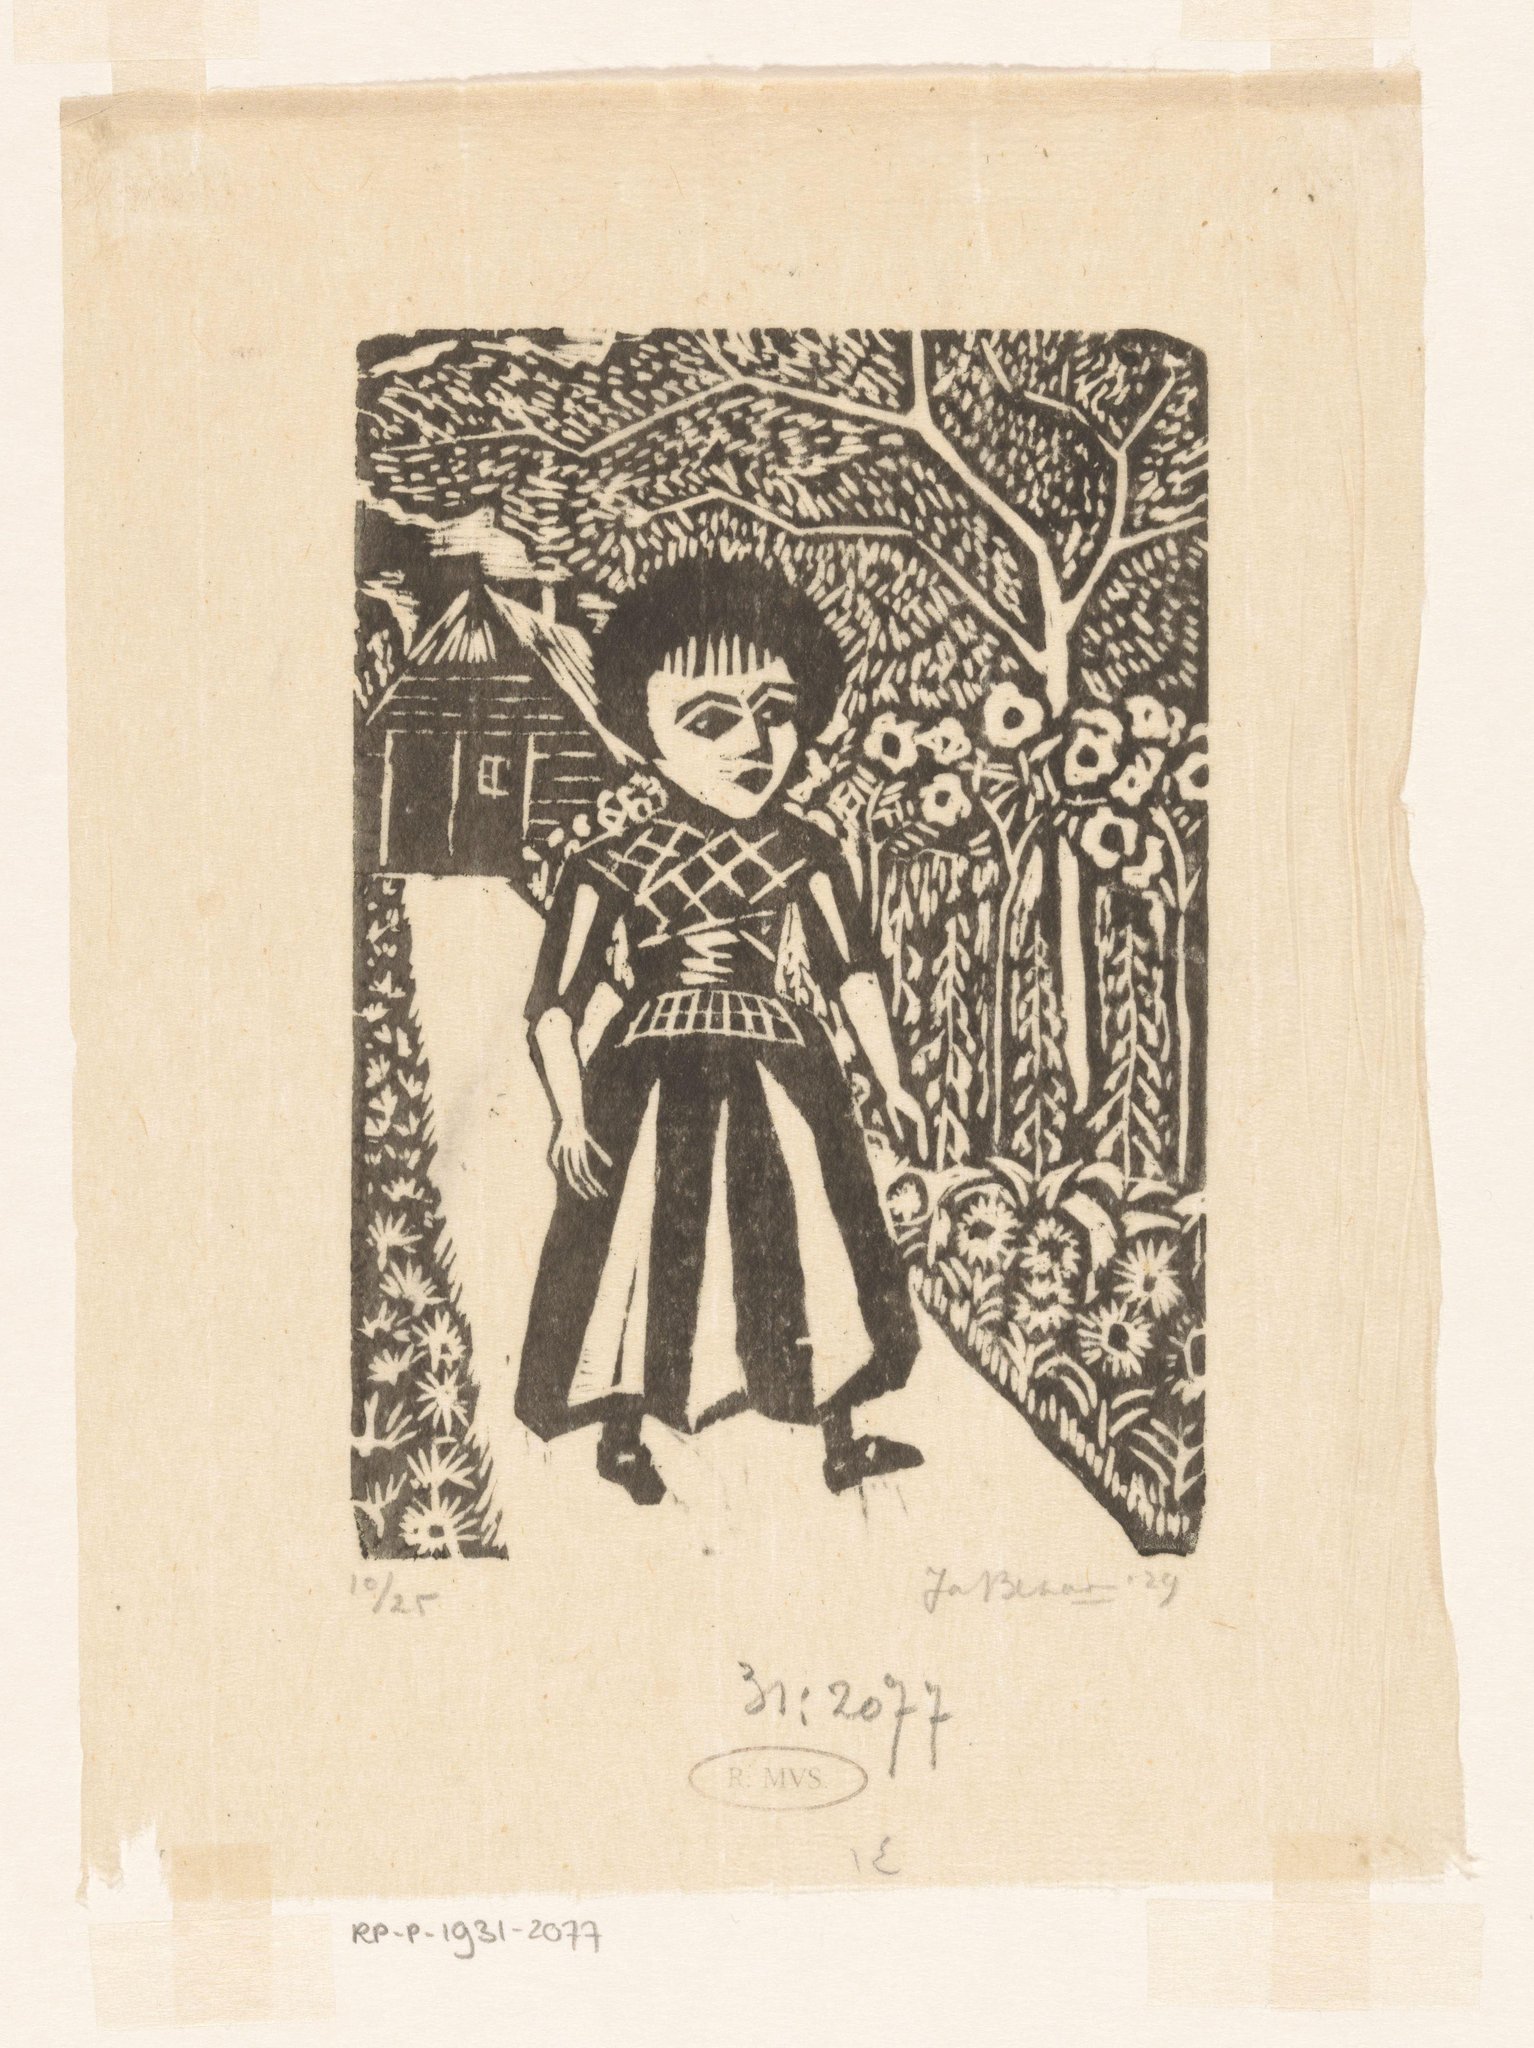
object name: print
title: Boerenmeisje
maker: jo bezaan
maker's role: draughtsman, print maker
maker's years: 1894-1952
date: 1929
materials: paper, ink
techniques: woodcut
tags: farmers - aa - female farmer, farmer's wife, folk costume, regional costume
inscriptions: edition: ‘10/25’, collector's mark: Lugt 2228, signature and date: ‘JoBezaan '29’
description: Boerenmeisje in klederdracht, lopend over een pad langs bloemen met op de achtergrond een huis.